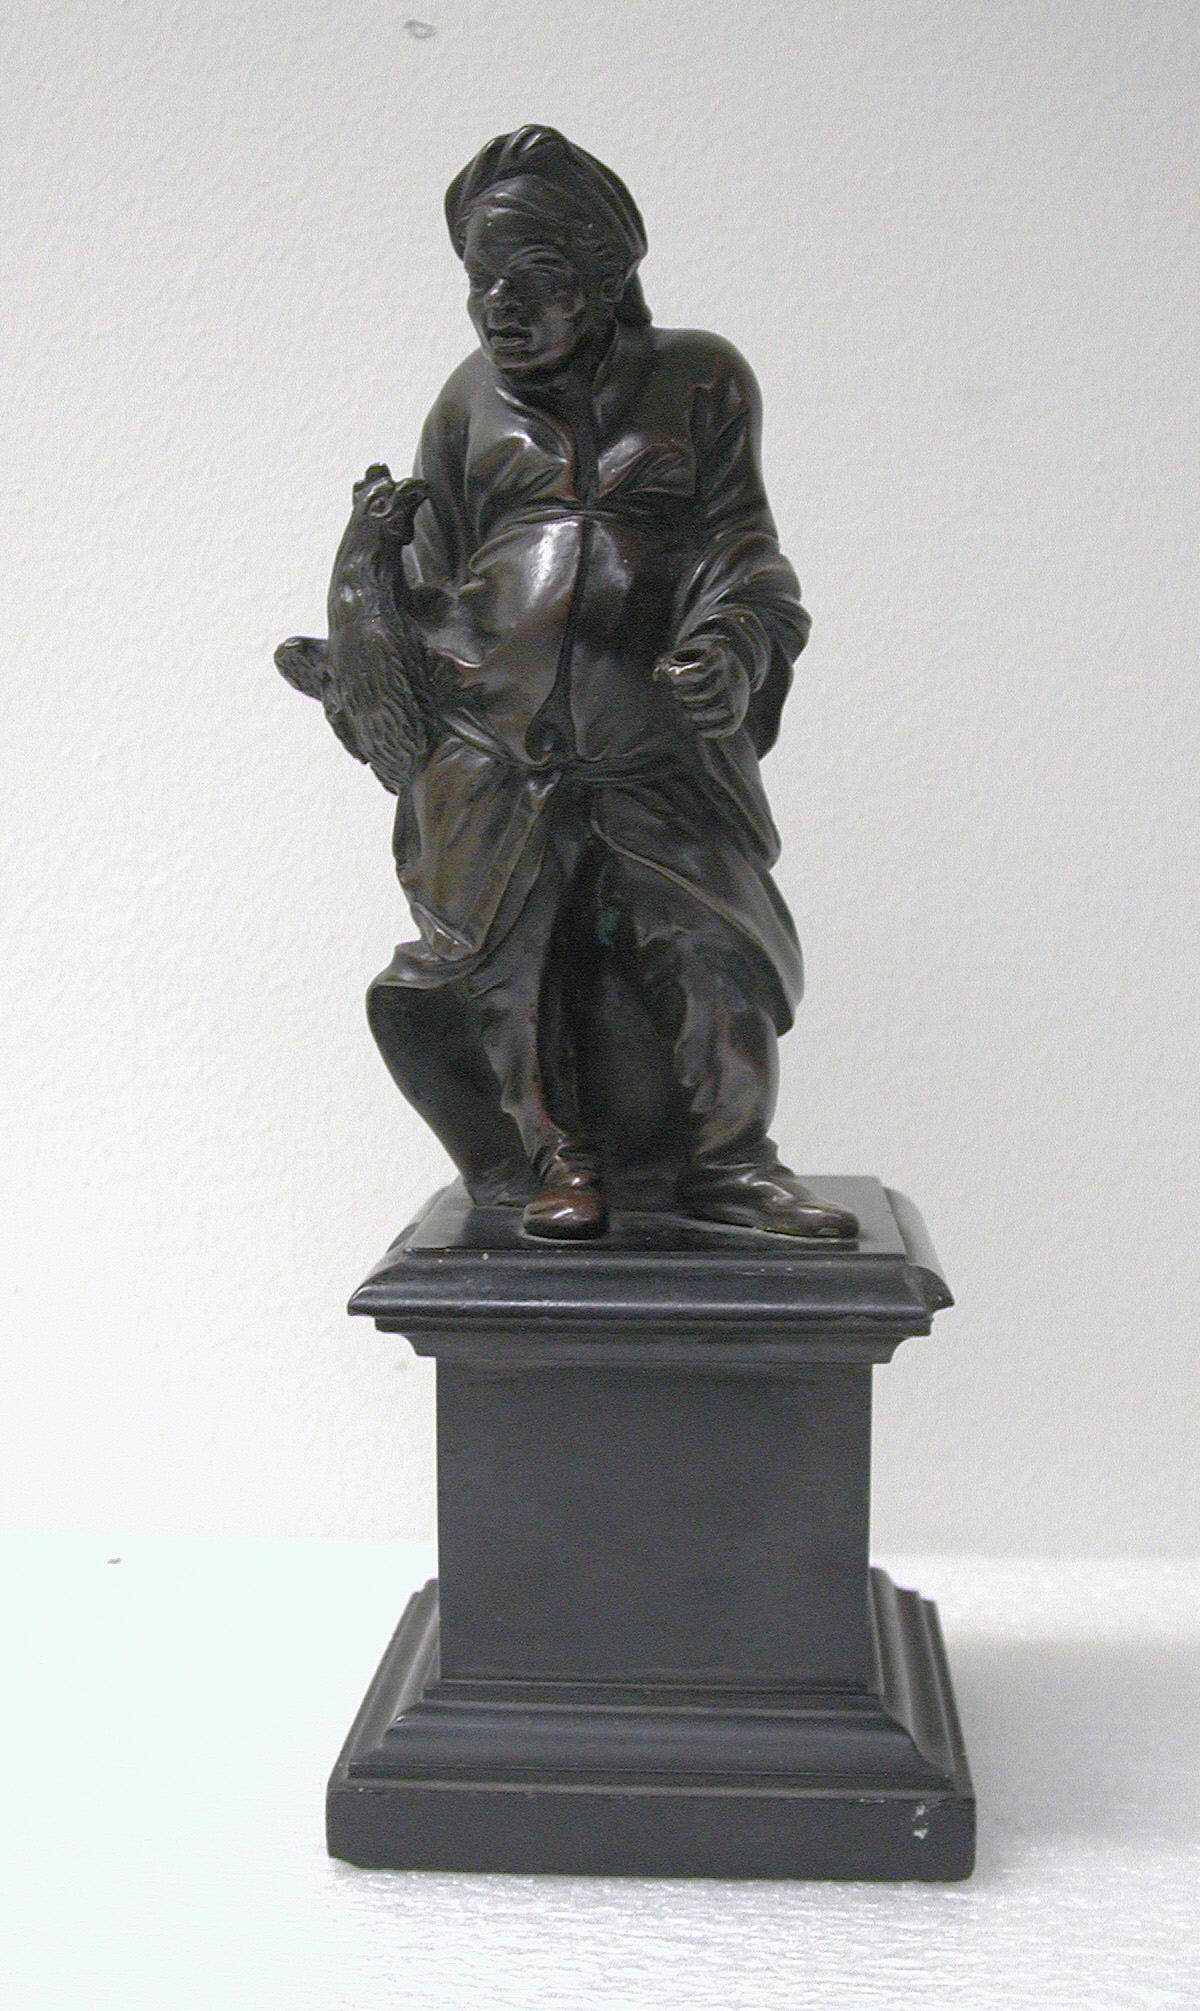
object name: statuette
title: Aesop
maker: pierre i legros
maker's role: artist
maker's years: 1629-1714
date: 1667-1700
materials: bronze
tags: men